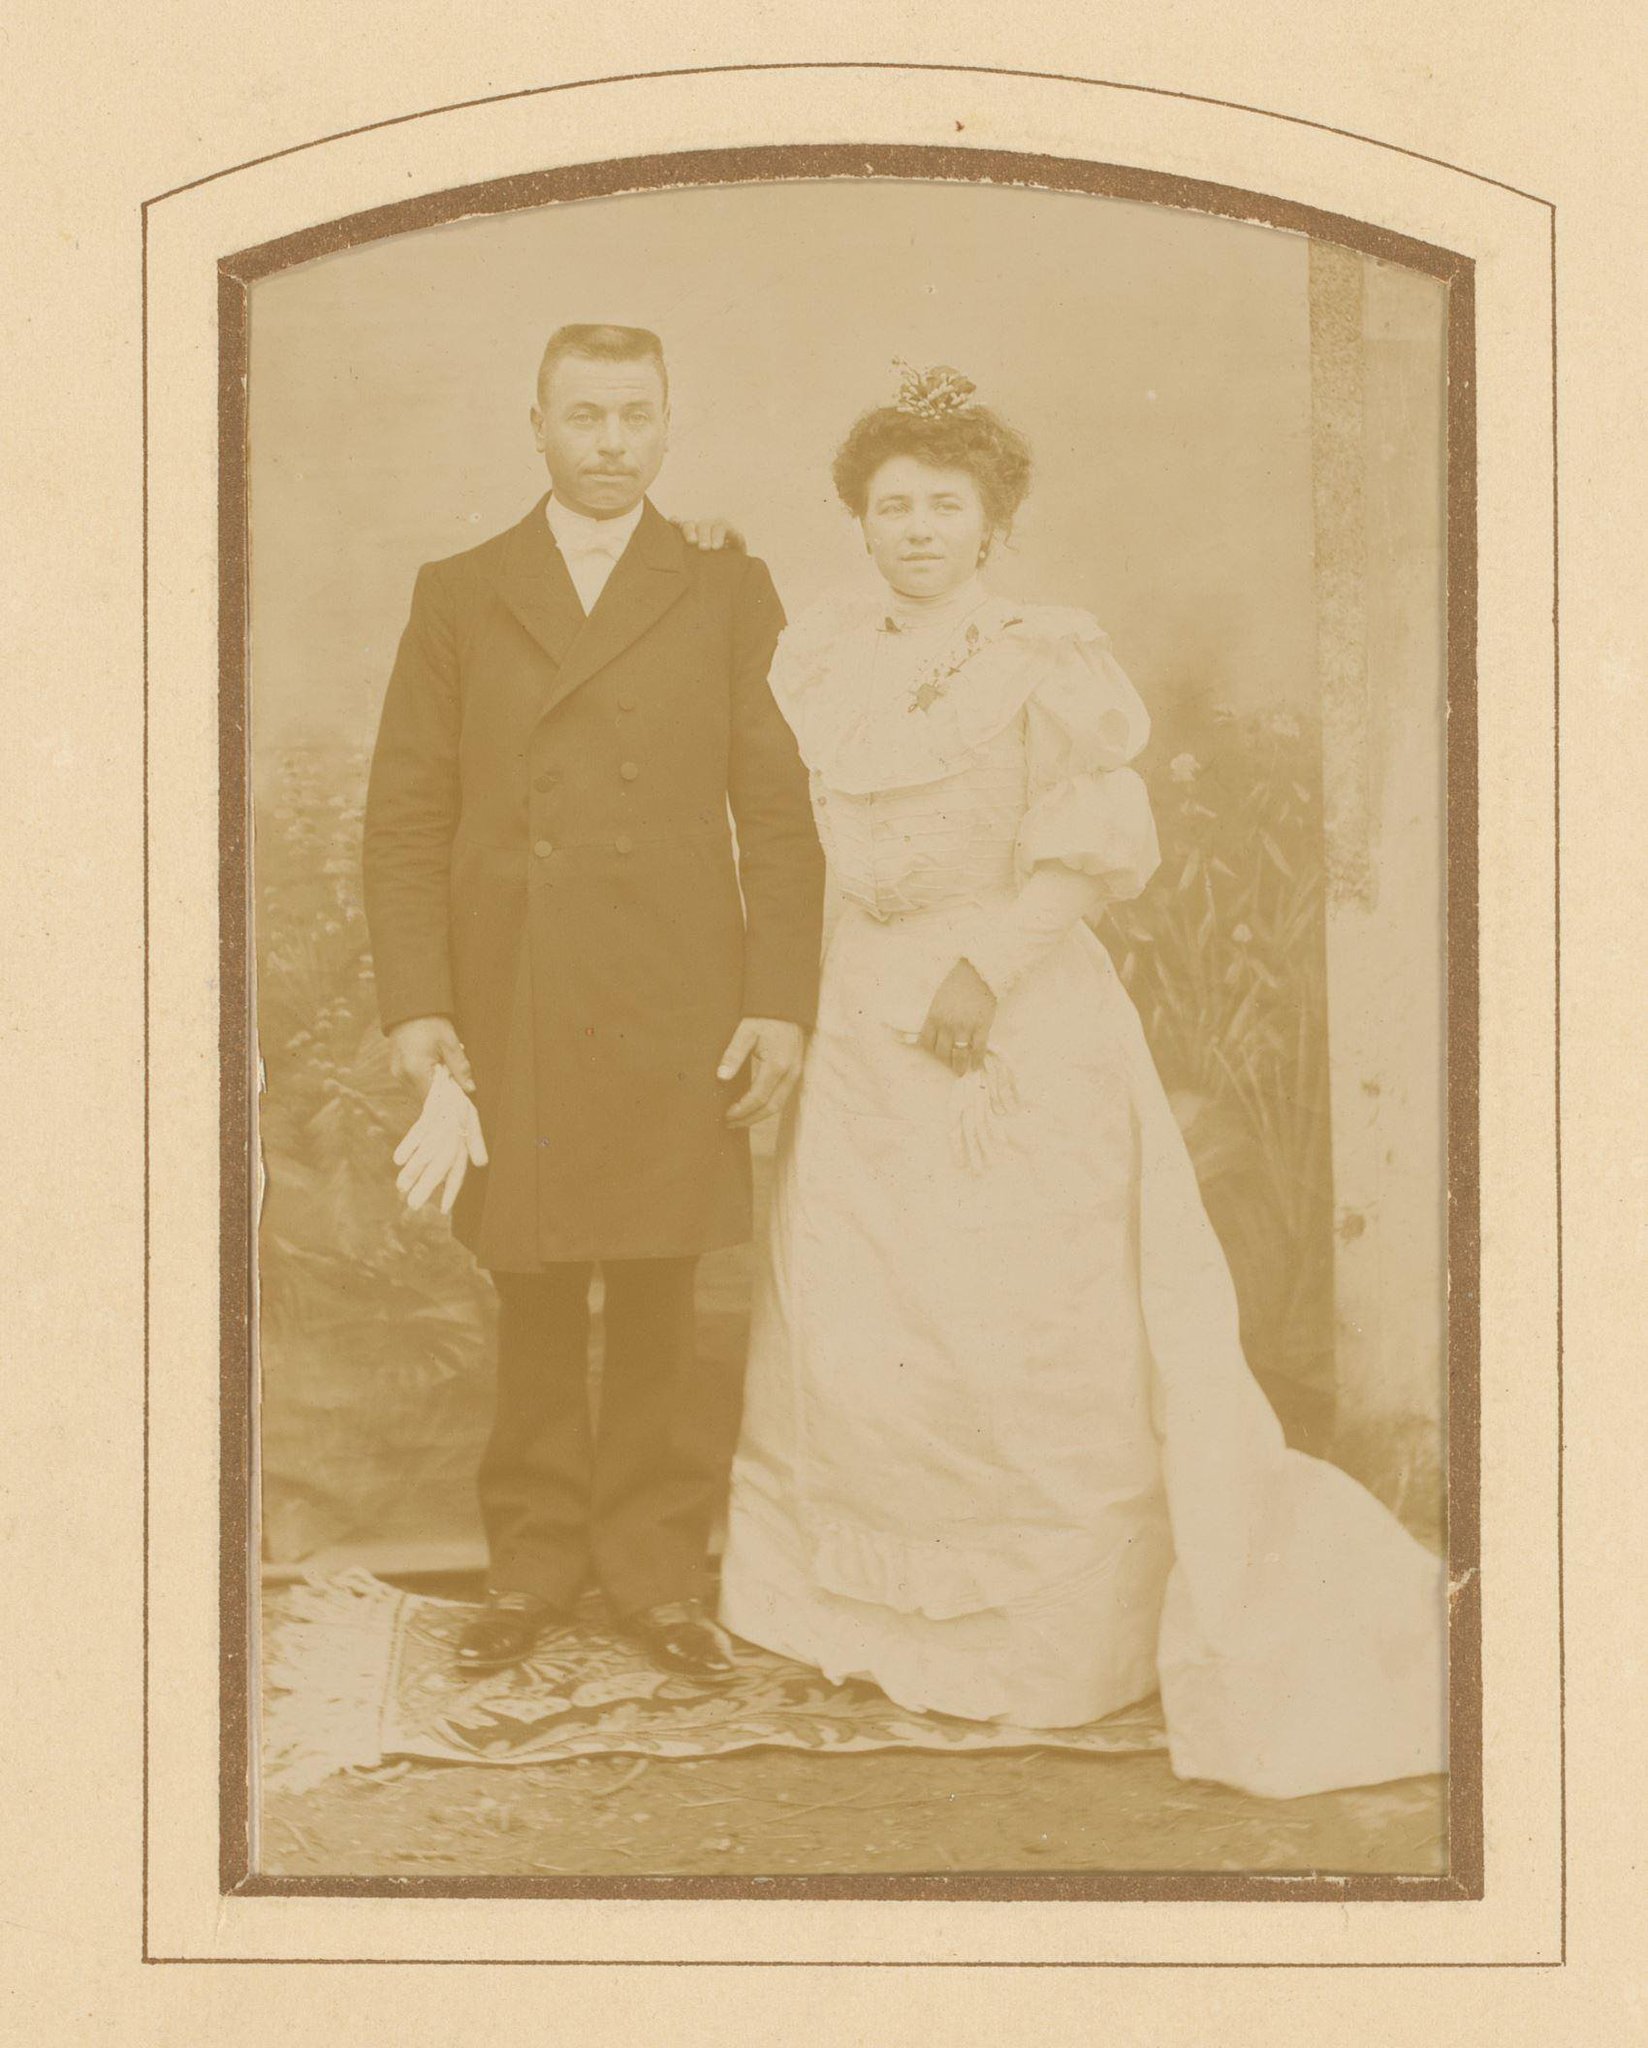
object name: cabinet photograph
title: Portret van een echtpaar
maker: Anonymous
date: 1890-1930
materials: cardboard, photographic support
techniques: gelatin silver print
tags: bride and groom in wedding-dress